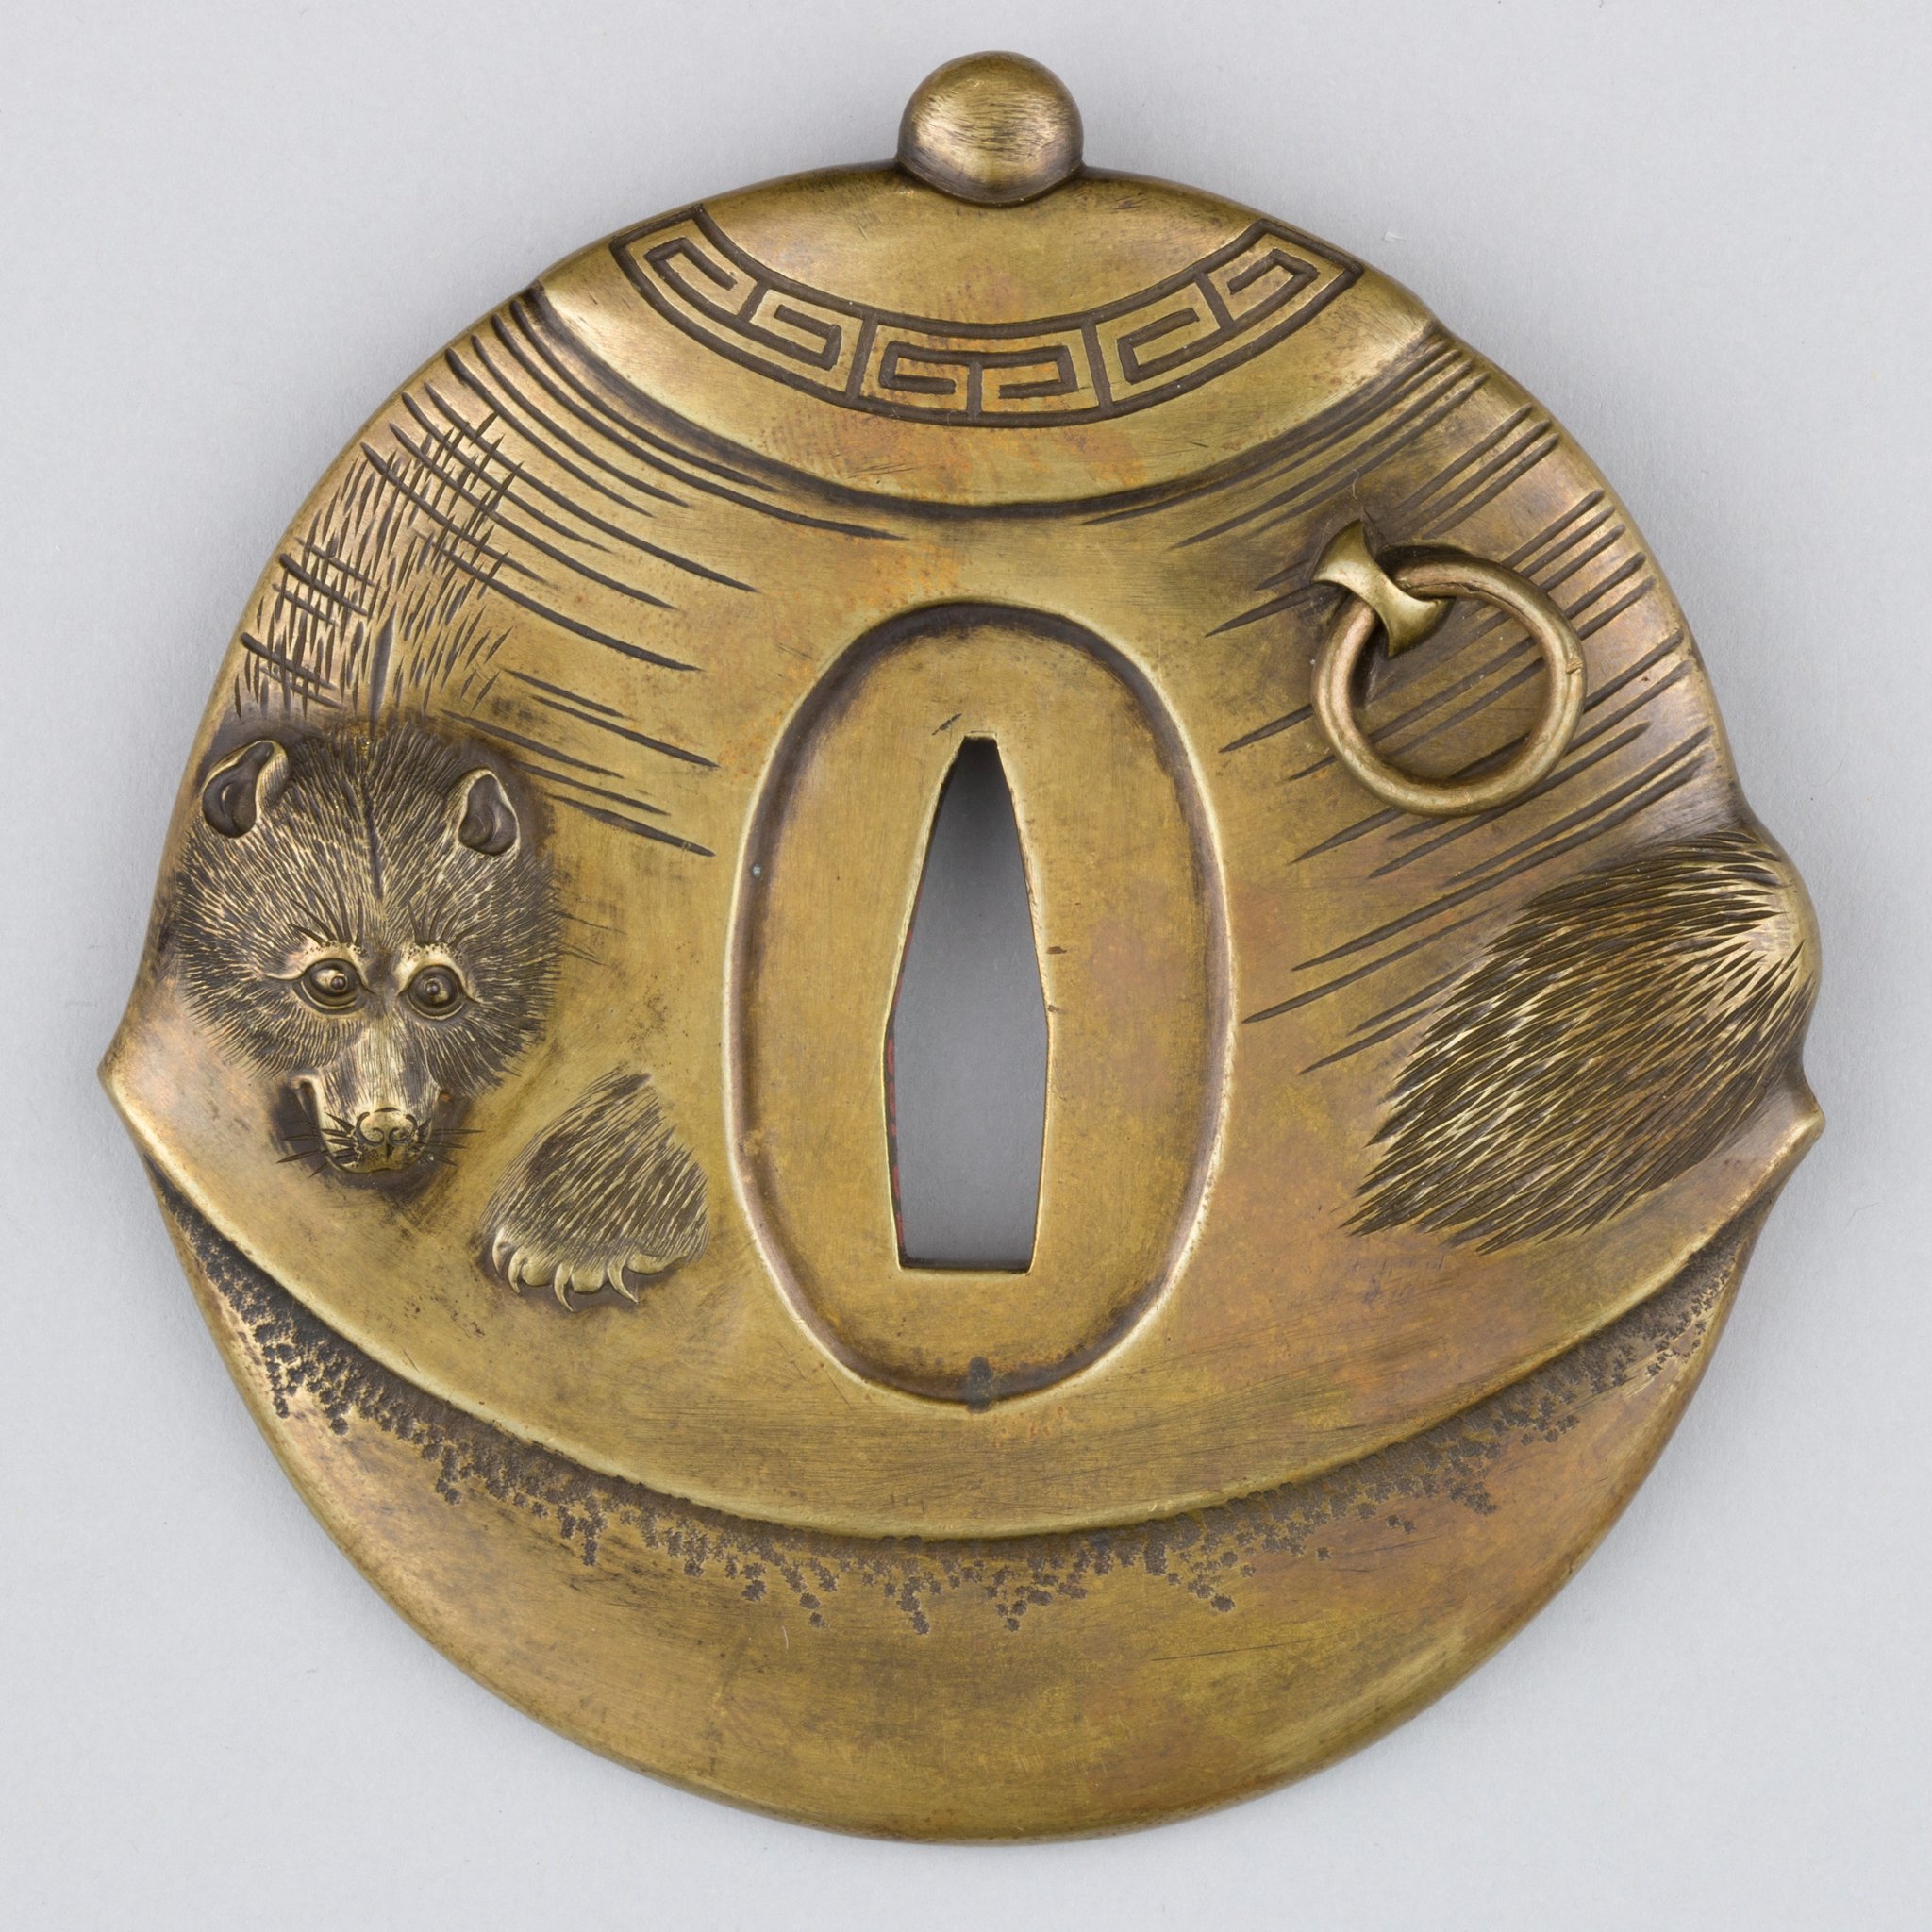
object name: sword guard tsuba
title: Sword Guard (Tsuba)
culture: japanese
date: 1615-1868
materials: copper, copper alloy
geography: japan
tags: bears